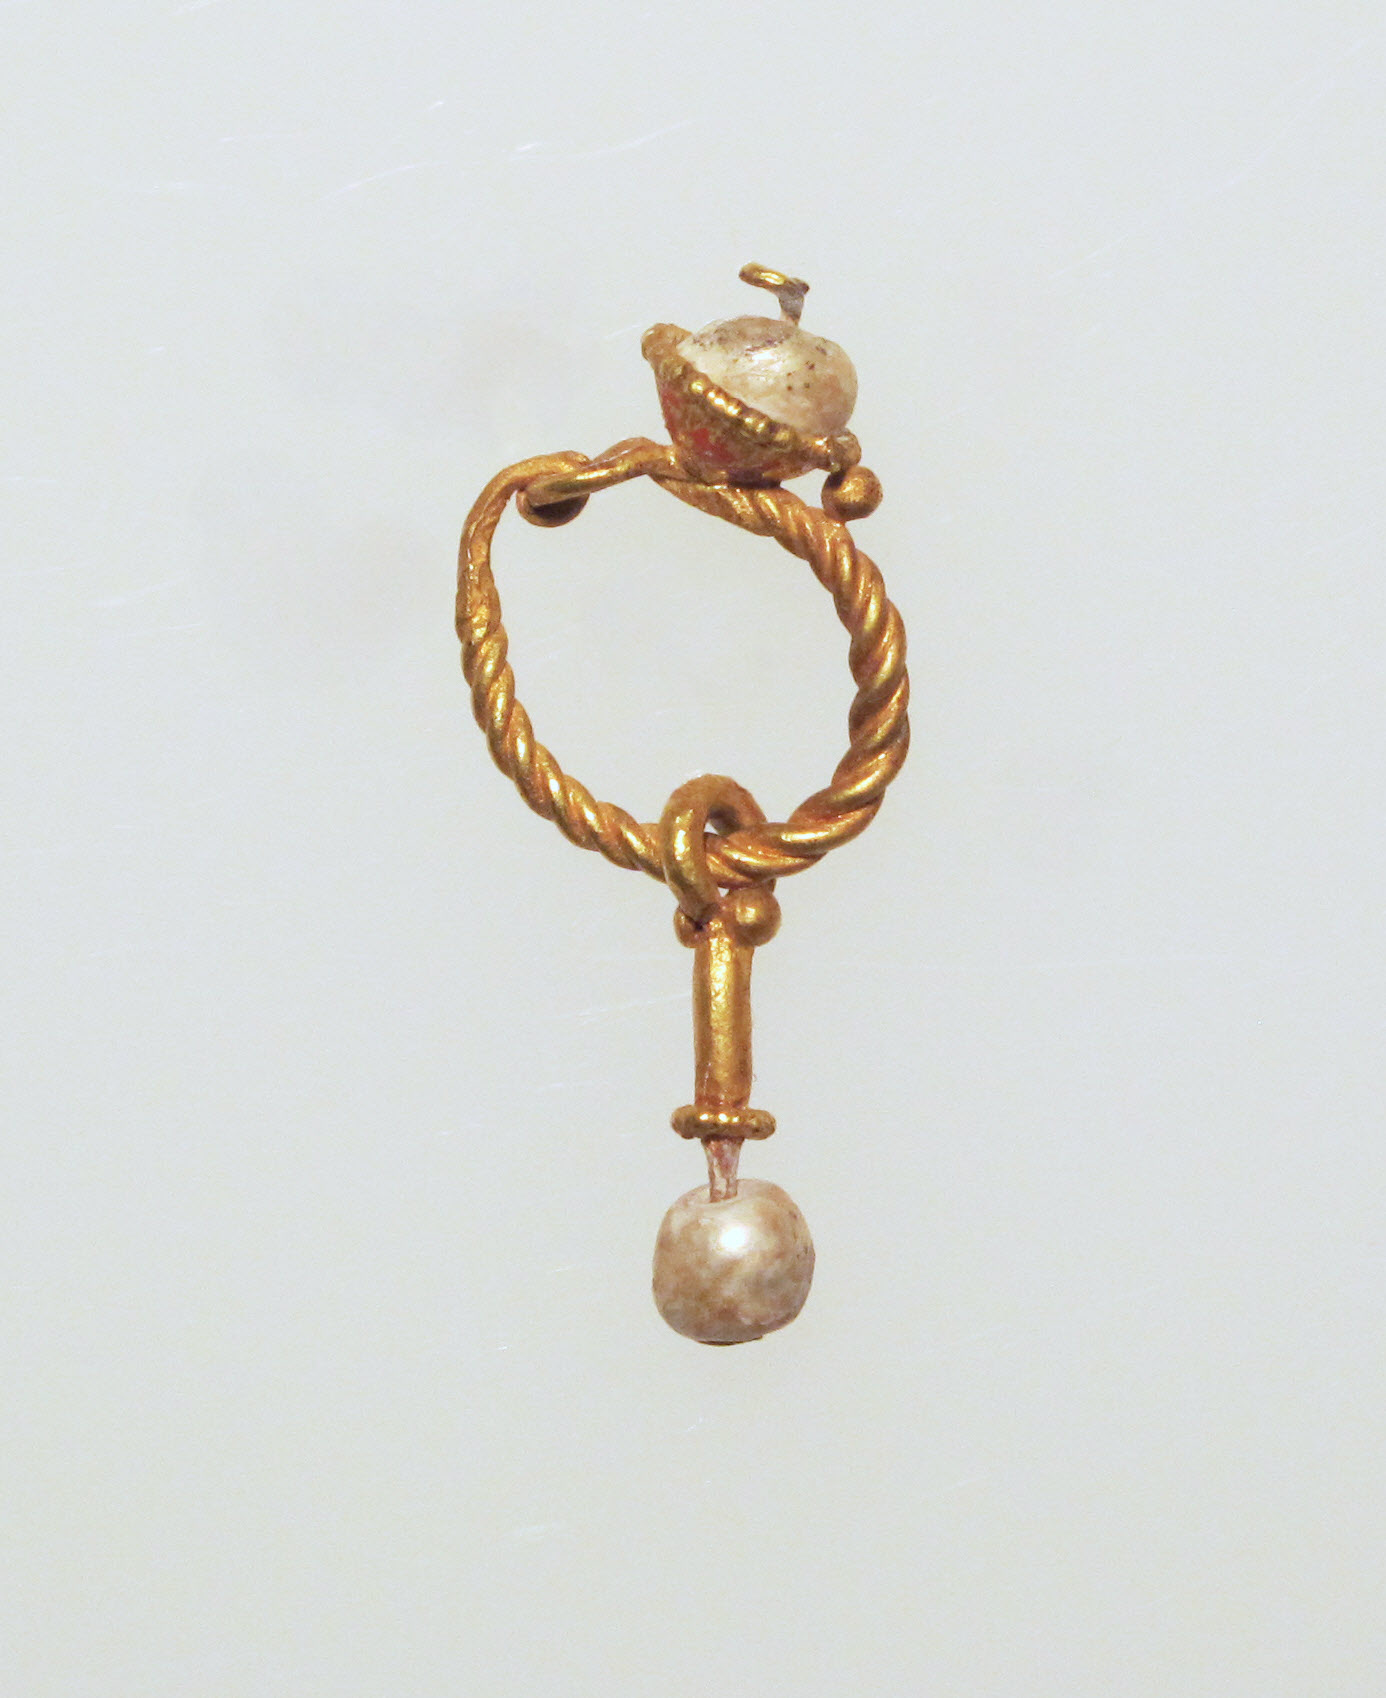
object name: earring with pendant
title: Gold earring with pearl pendant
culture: roman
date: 1-200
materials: gold